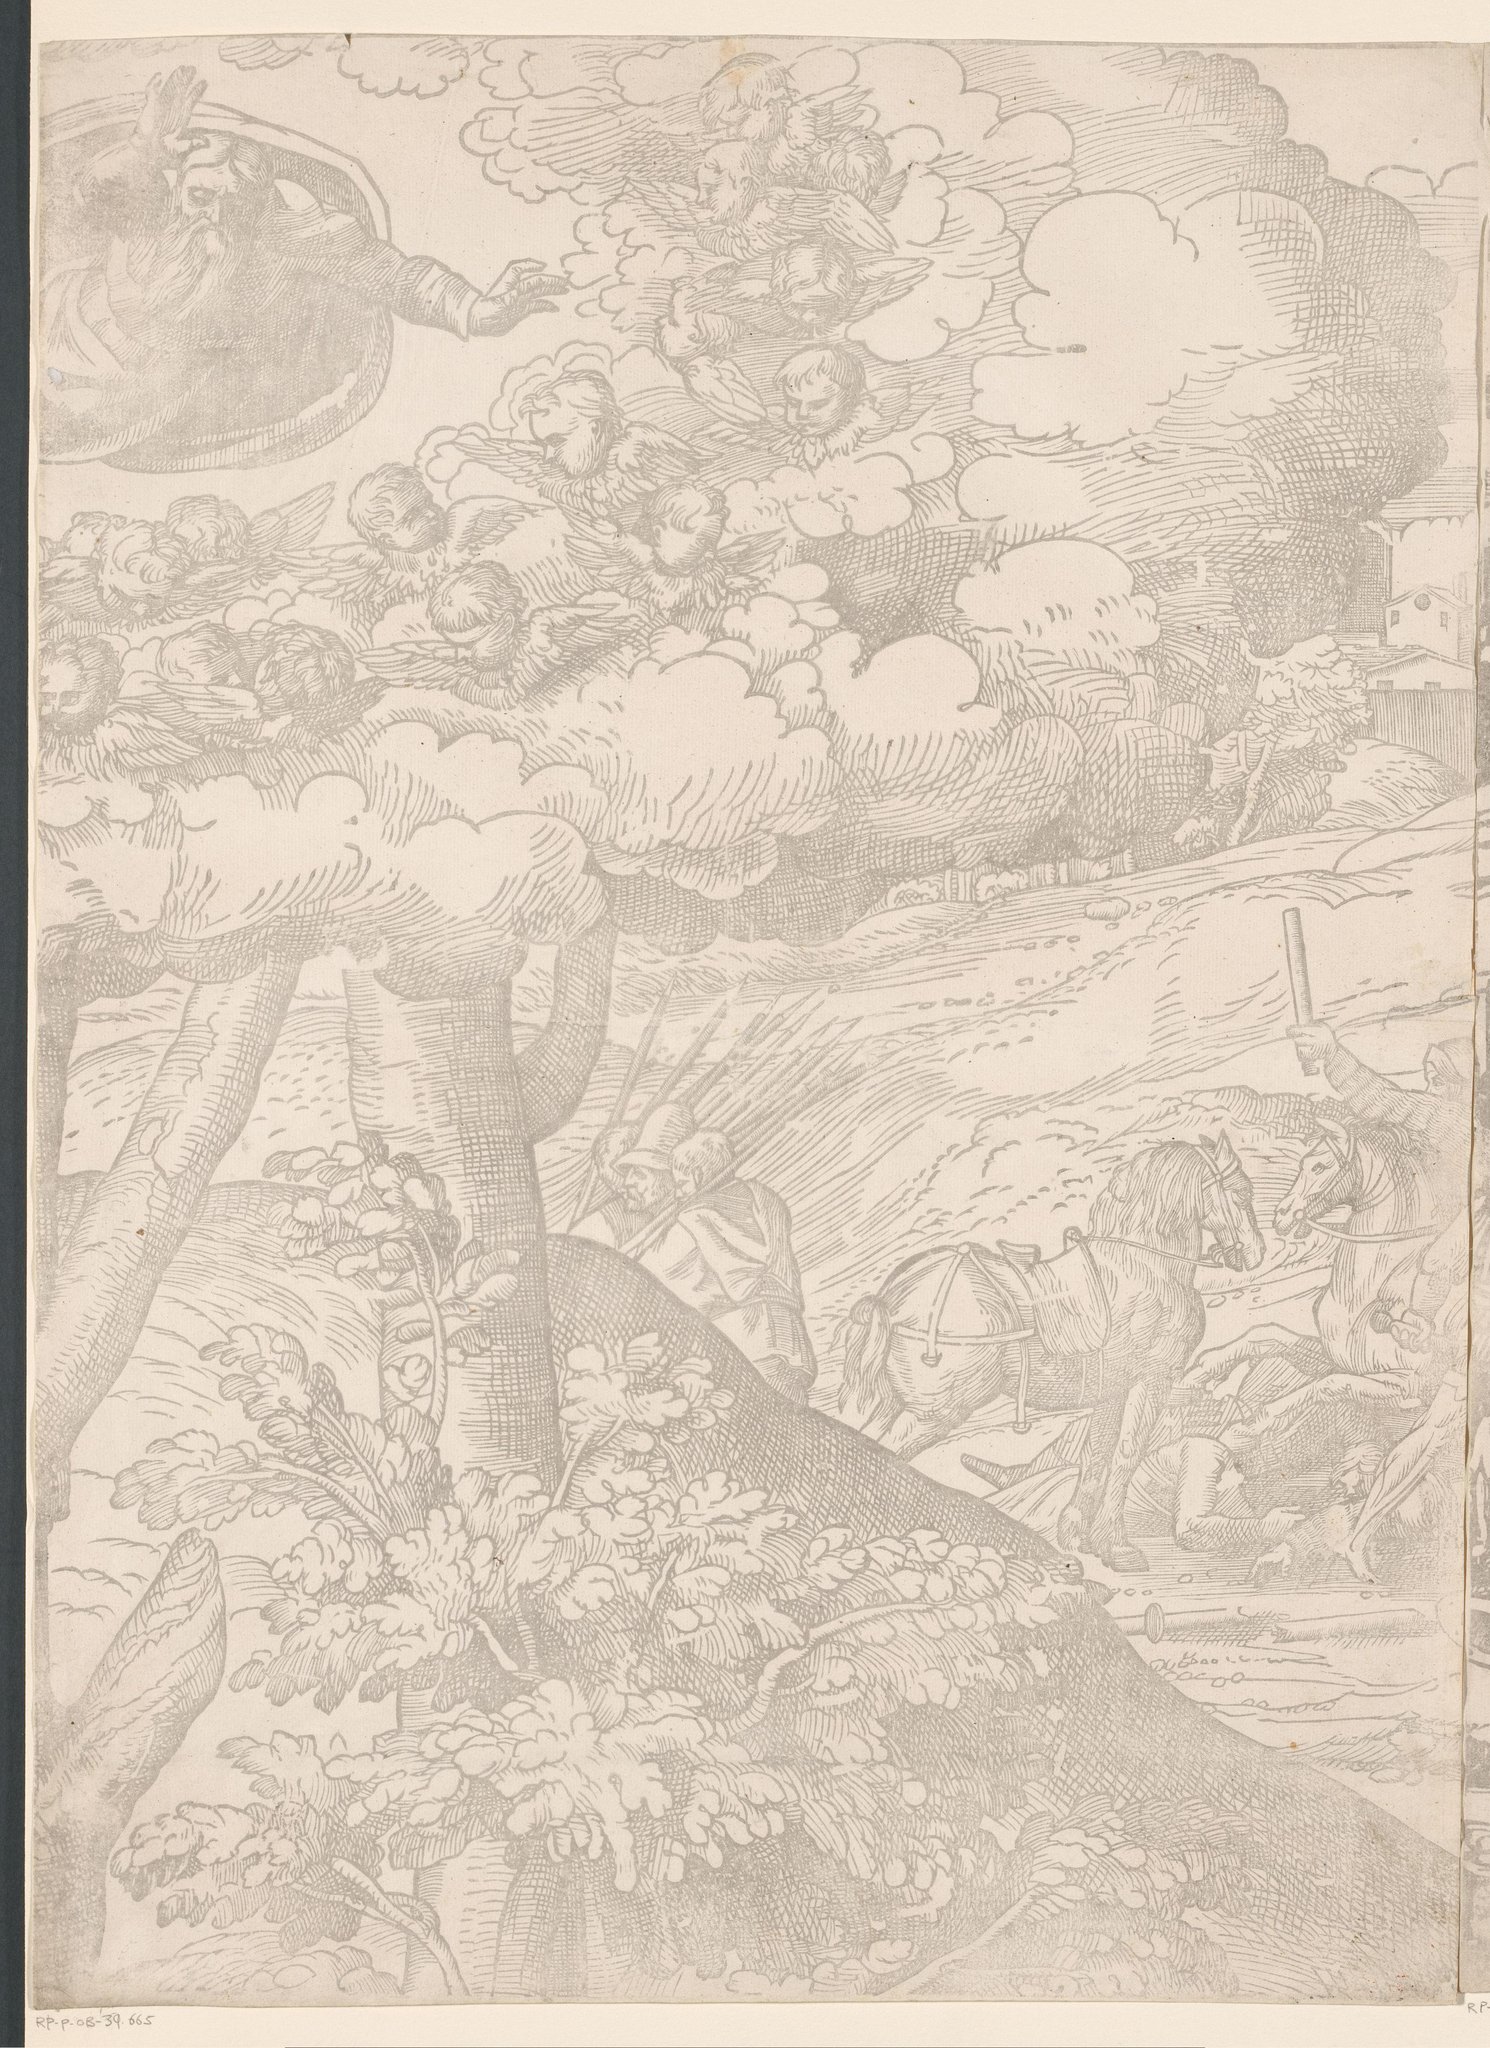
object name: print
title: Martelaarschap van de tienduizend (derde deel)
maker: domenico campagnola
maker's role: draughtsman, painter, print maker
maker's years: 1500-1564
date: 1515-1520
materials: paper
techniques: printmaking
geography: italy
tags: city-view in general; 'veduta', god the father, the martyrdom of achatius and his 10.000 companions on mount ararat: they are crucified and/or impaled on trees or thorns, cupids: 'amores', 'amoretti', 'putti'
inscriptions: collector's mark: Lugt 240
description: De Romeinse legerleider Achatius van Ararat en zijn 10.000 volgelingen zijn ter dood gebracht omdat zij zich hadden bekeerd tot het christendom. In het midden worden zij aan bomen gehangen, en rechts worden zij van de rotsen gegooid. Midden boven God de Vader omringd door putti.